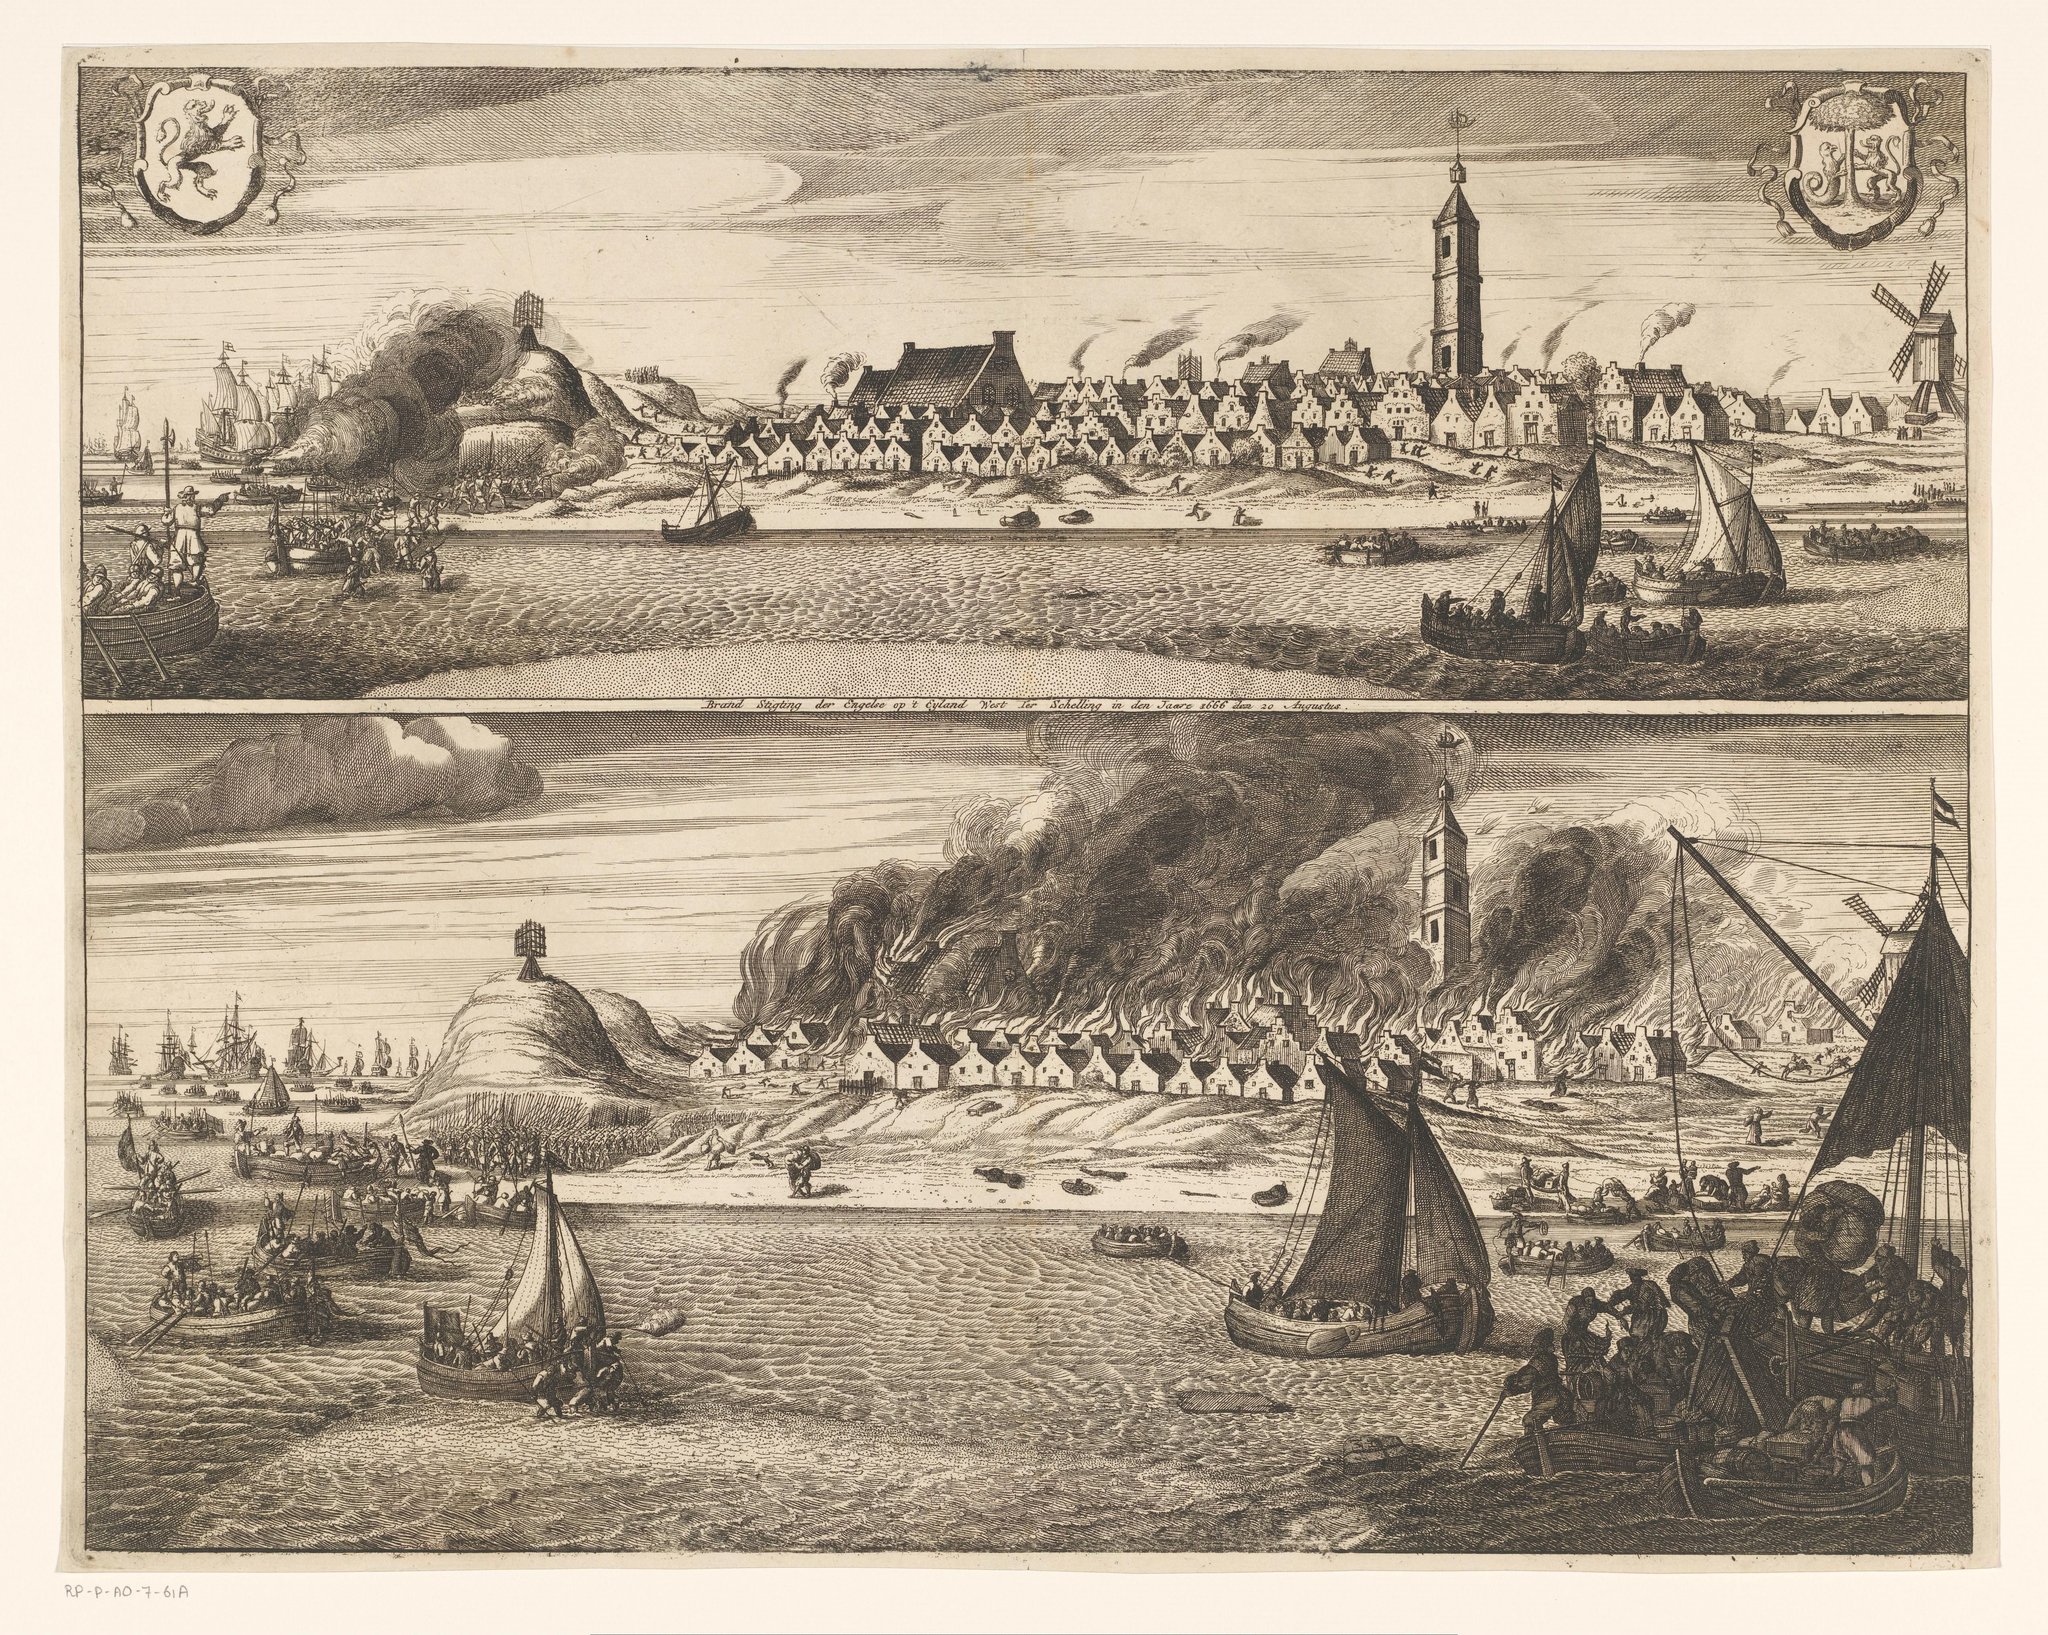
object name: print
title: Brand stigting der Engelse op 't eyland West Ter Schelling in den jaare 1666 den 20 augustus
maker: harmen de mayer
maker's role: print maker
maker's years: 1624-1701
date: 1666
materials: paper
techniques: engraving, etching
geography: northern netherlands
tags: on fire, ablaze, setting on fire (of conquered city), holmes's bonfire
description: Blad met twee voorstellingen. Boven de landing van de Engelsen troepen onder kapitein Robert Holmes en enkele gevechten. In de lucht links het wapen van Holland en rechts dat van Terschelling. Onder het dorp West-Terschelling in brand, 20 augustus 1666.